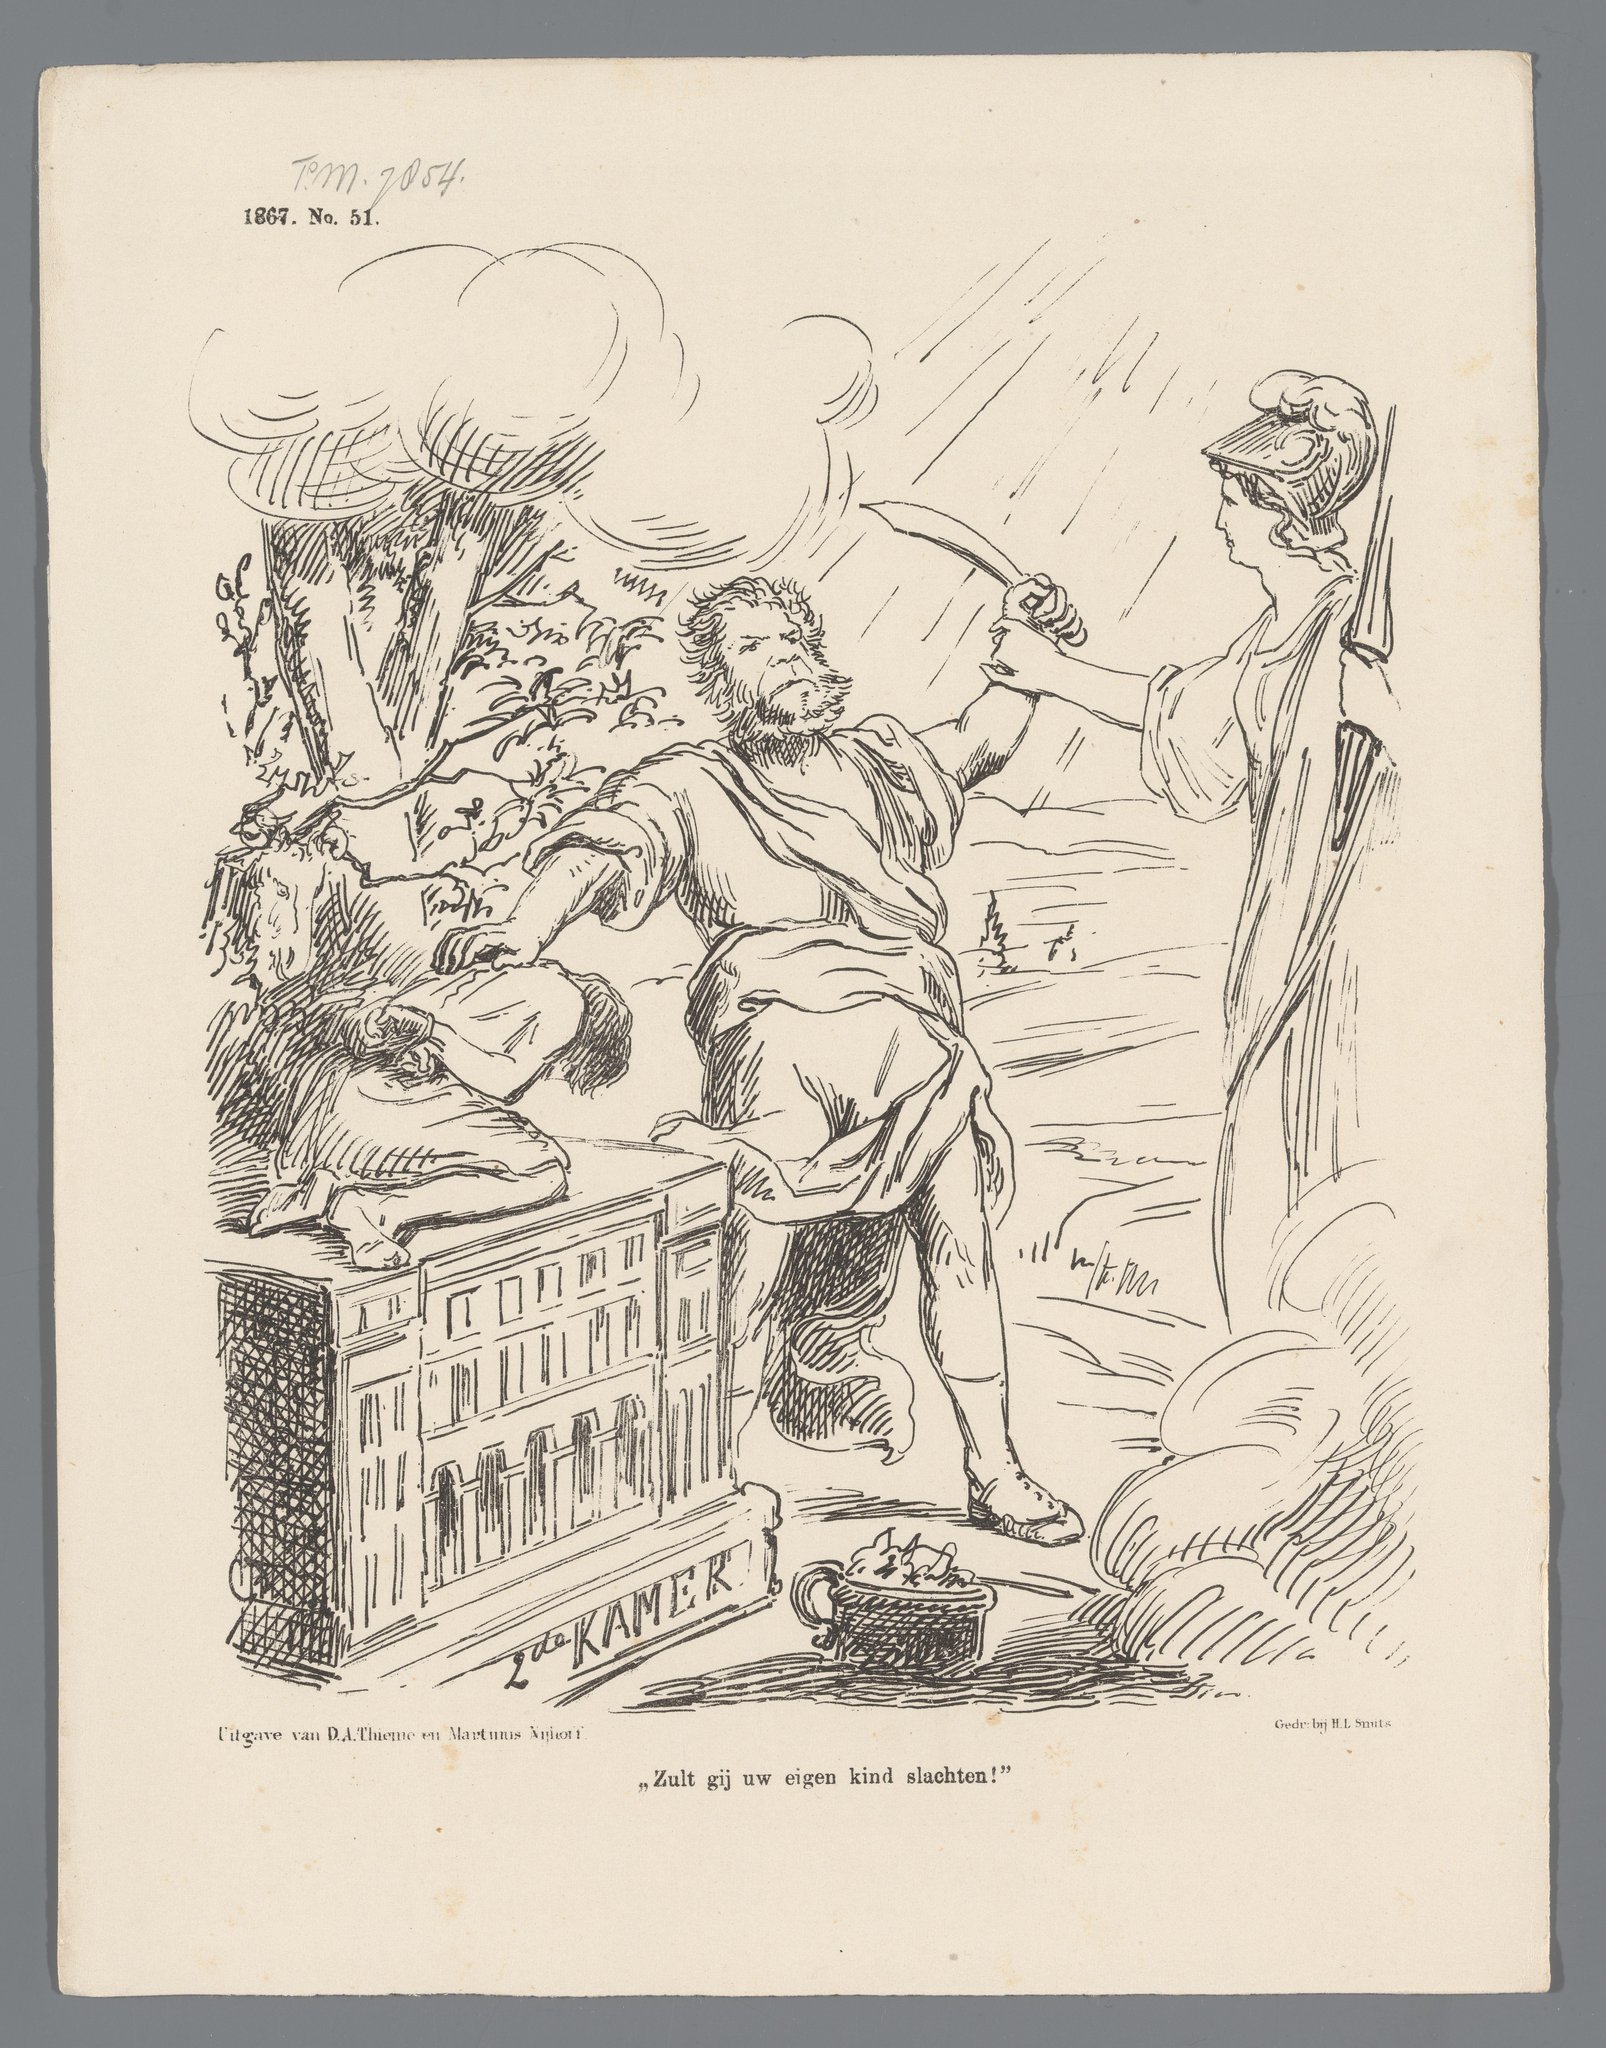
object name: cartoon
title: Spotprent op minister Van Zuylen, 1867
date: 1867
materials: paper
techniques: lithograph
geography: netherlands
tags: earl, personifications of countries, nations, states, districts, etc., when abraham has his hand raised to kill isaac, god or the hand of god restrains abraham's hand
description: Spotprent op minister Van Zuylen die als Abraham klaar staat op zijn eigen kind (minister Hasselman?) op het altaar (Tweede Kamer) te offeren. De Nederlandse Maagd houdt hem tegen. Plaat verschenen bij het weekblad De Nederlandsche Spectator, nr. 51, 21 december 1867.